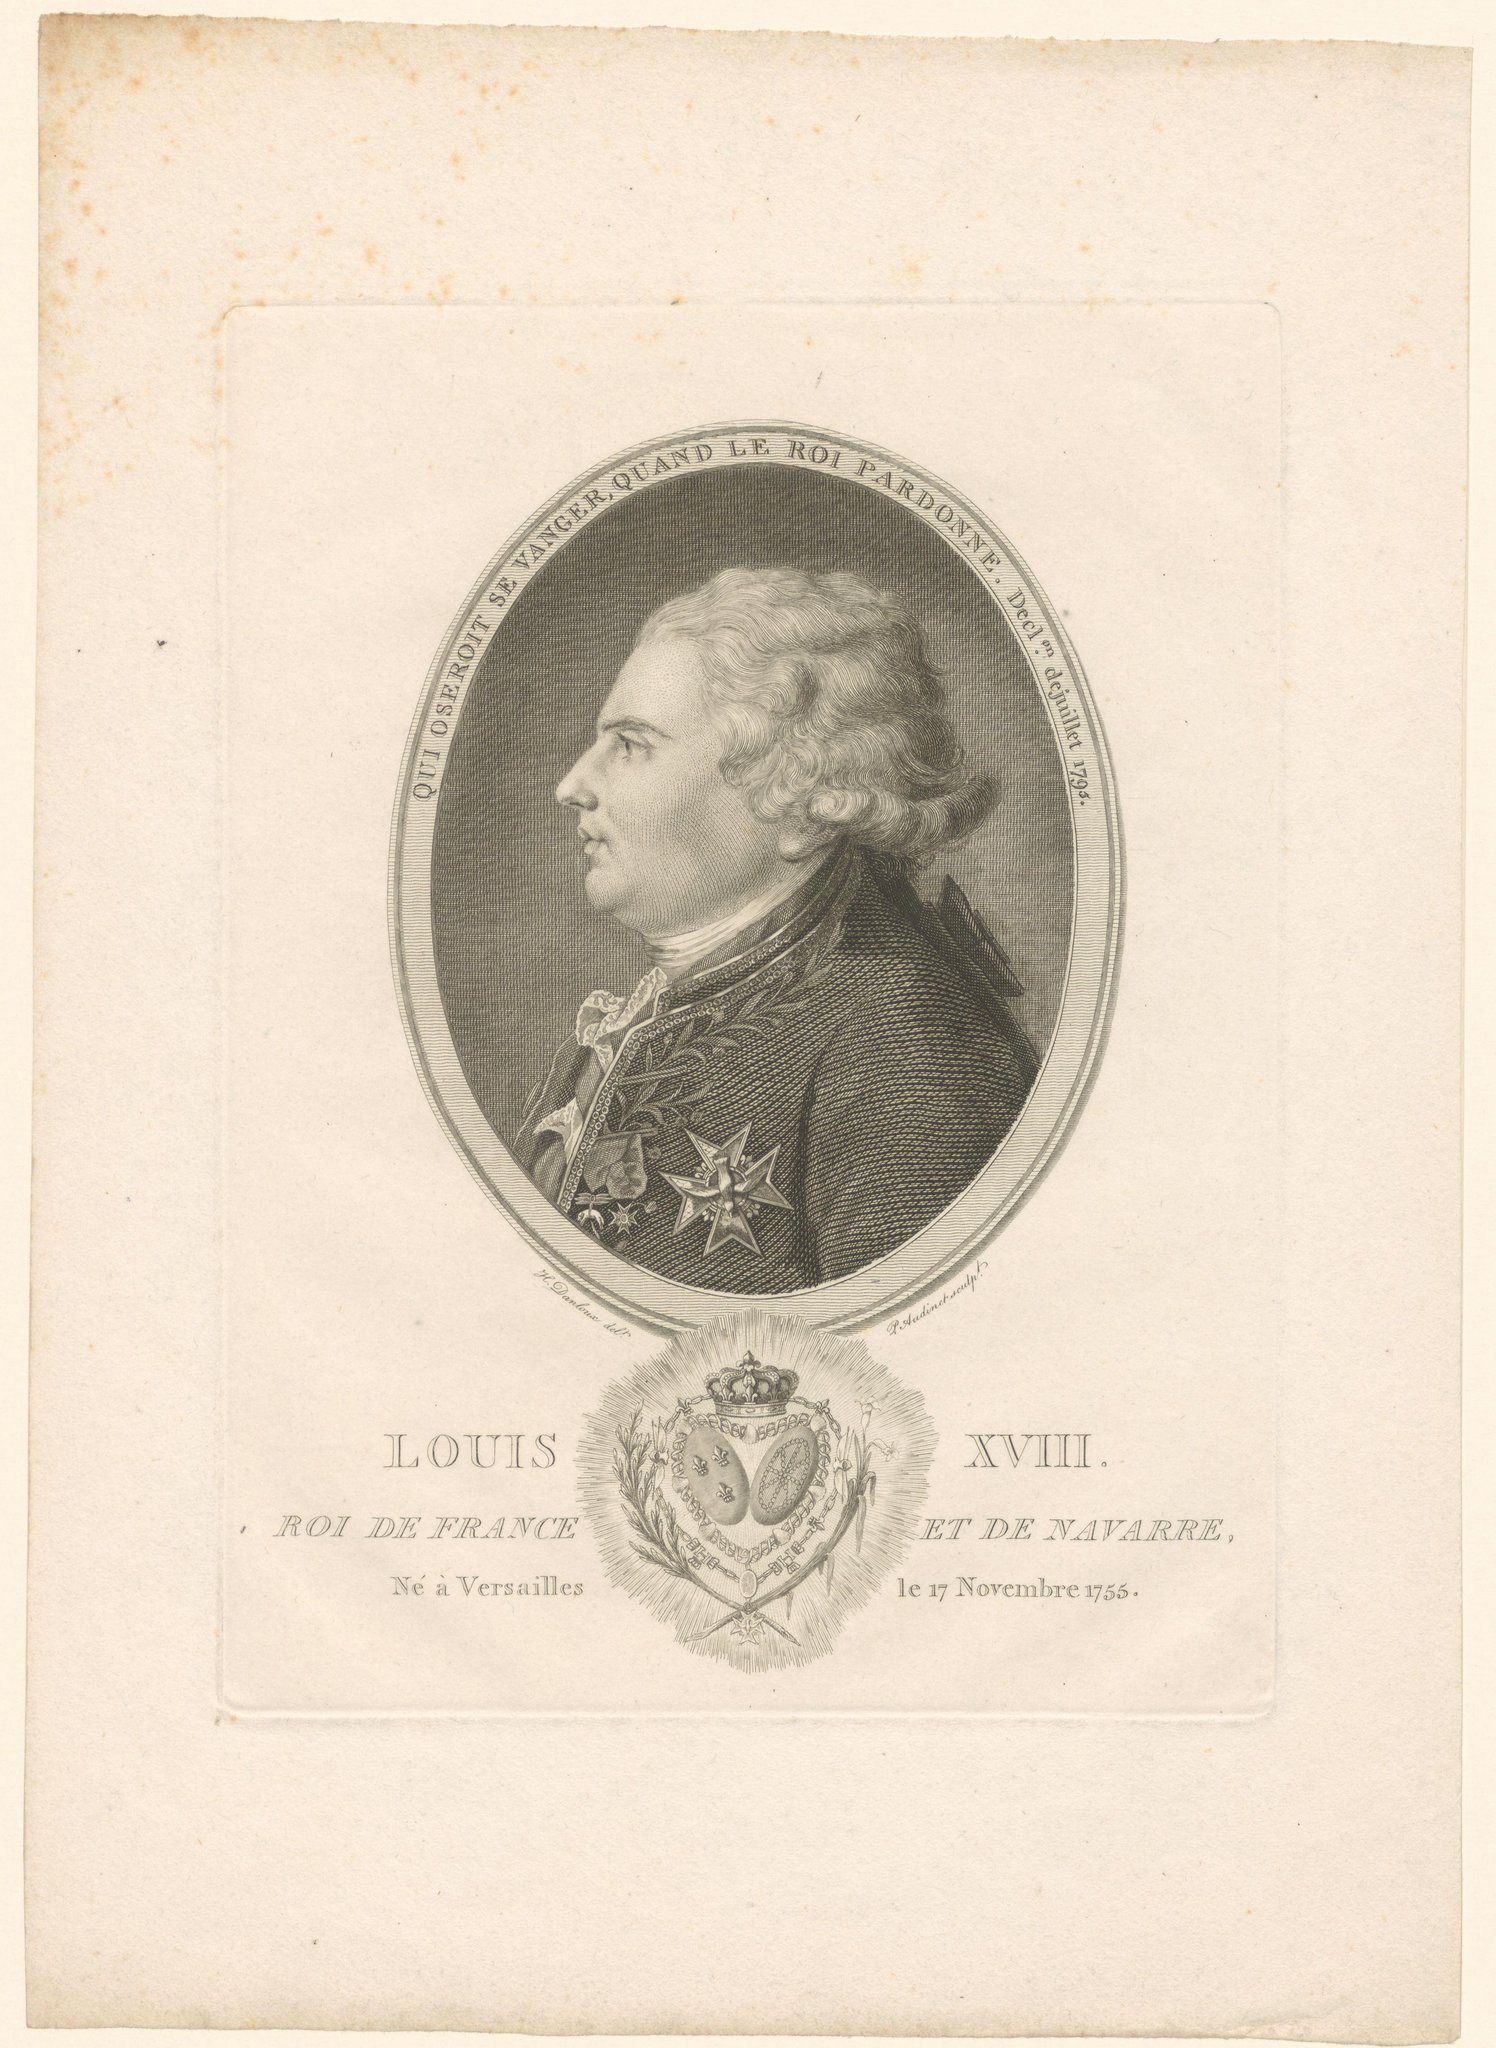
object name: print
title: Portret van Lodewijk XVIII van Frankrijk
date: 1814-1824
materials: paper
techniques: engraving, etching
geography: london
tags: paris, lodewijk xviii (koning van frankrijk), historical persons, king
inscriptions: collector's mark: Lugt 2228